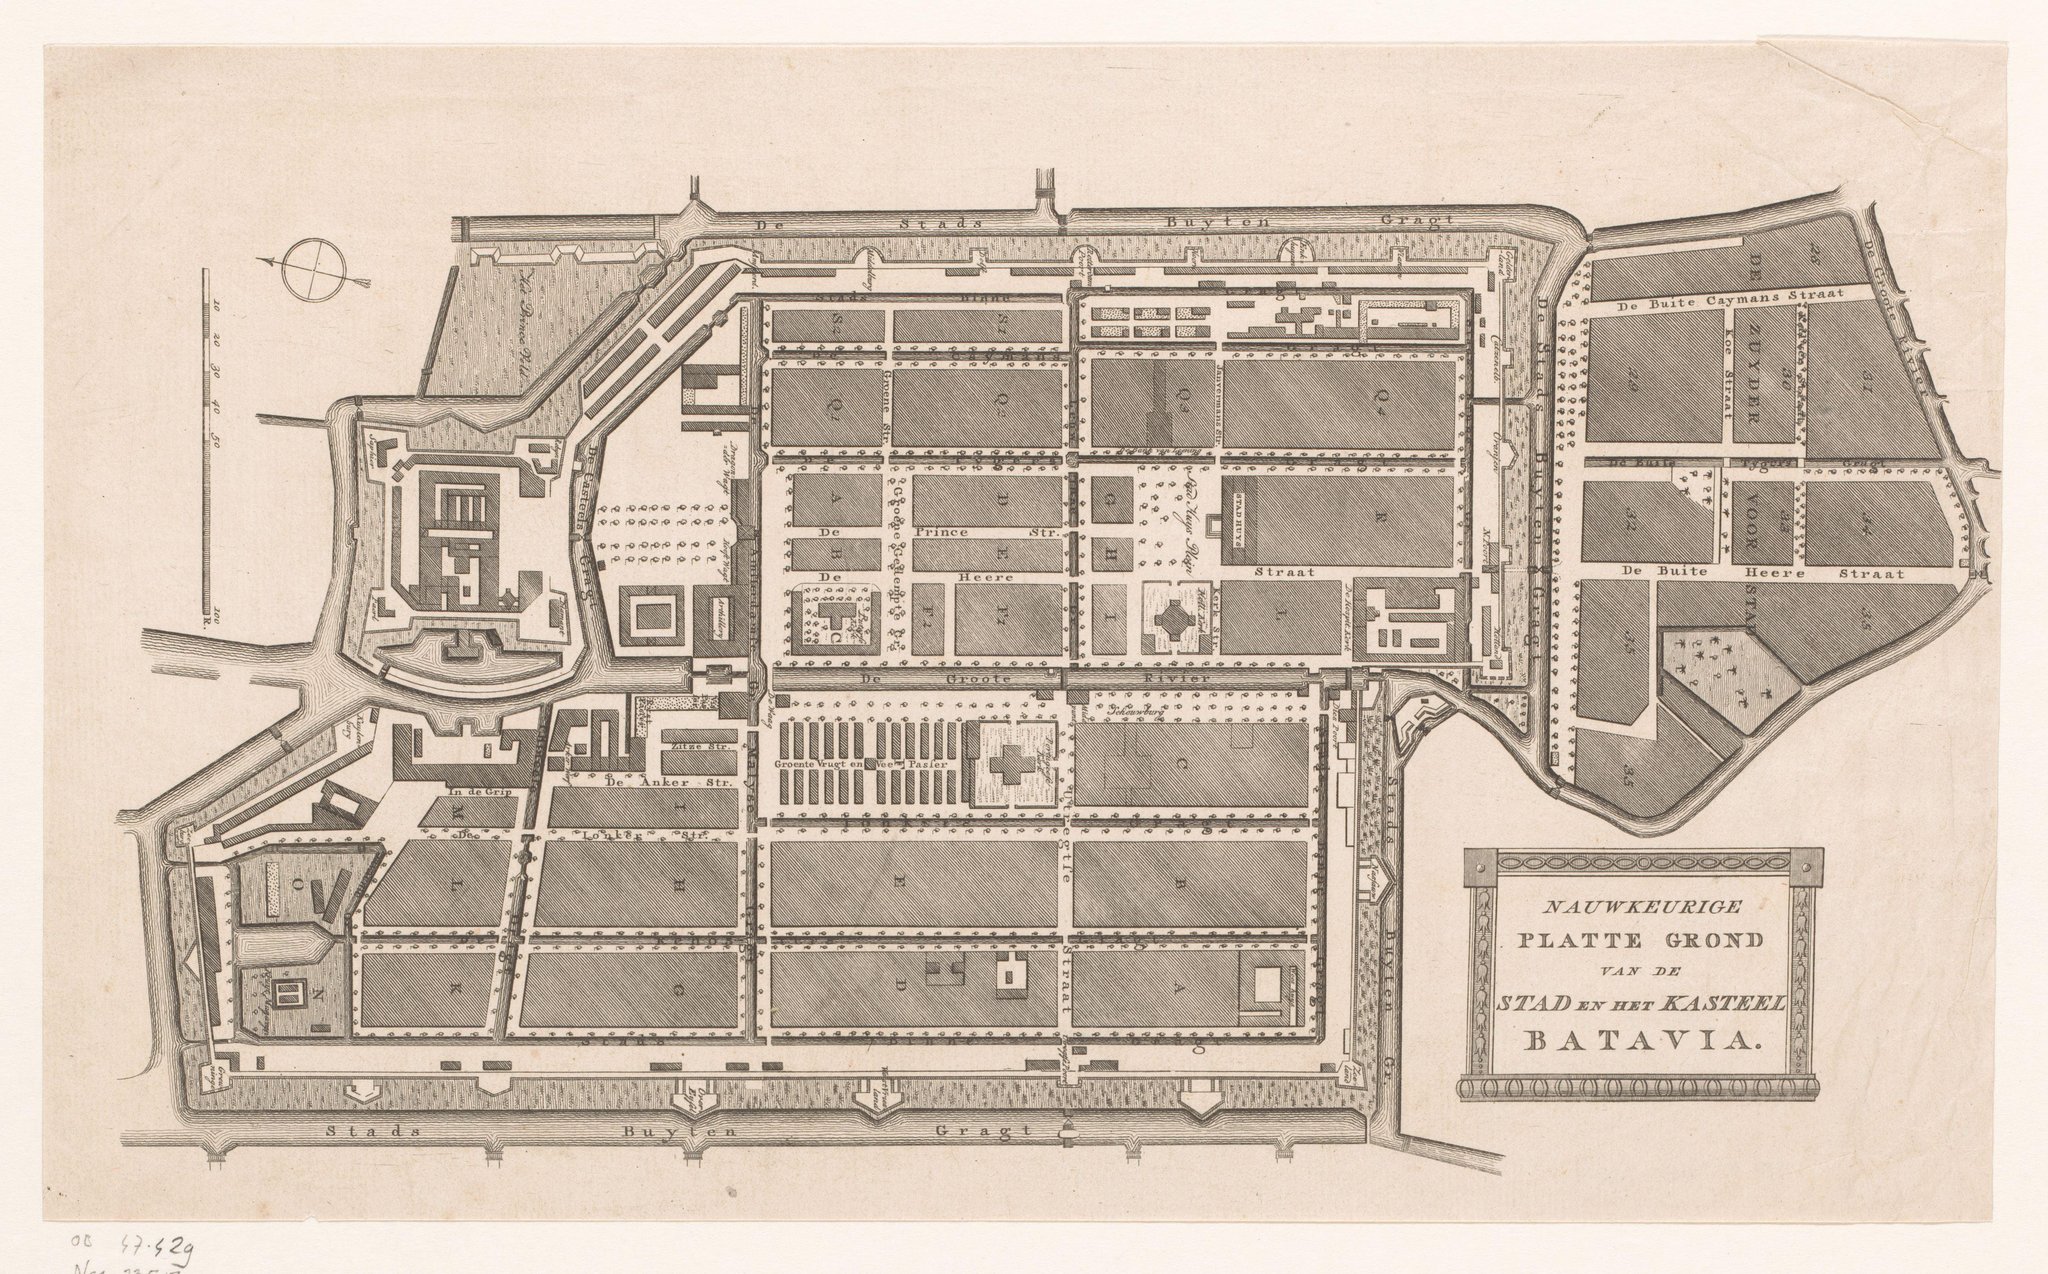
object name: book illustration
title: Plattegrond van Batavia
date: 1781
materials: paper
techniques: engraving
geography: rotterdam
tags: maps of cities, batavia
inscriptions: collector's mark: Lugt 2228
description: Prent uit: Verhandelingen van het Bataviaasch Genootschap der Kunsten en Wetenschappen. 61 dln. Rotterdam en Amsterdam: Reinier Arrenberg en Johannes Allart, 1781, dl. 1, p. 42.